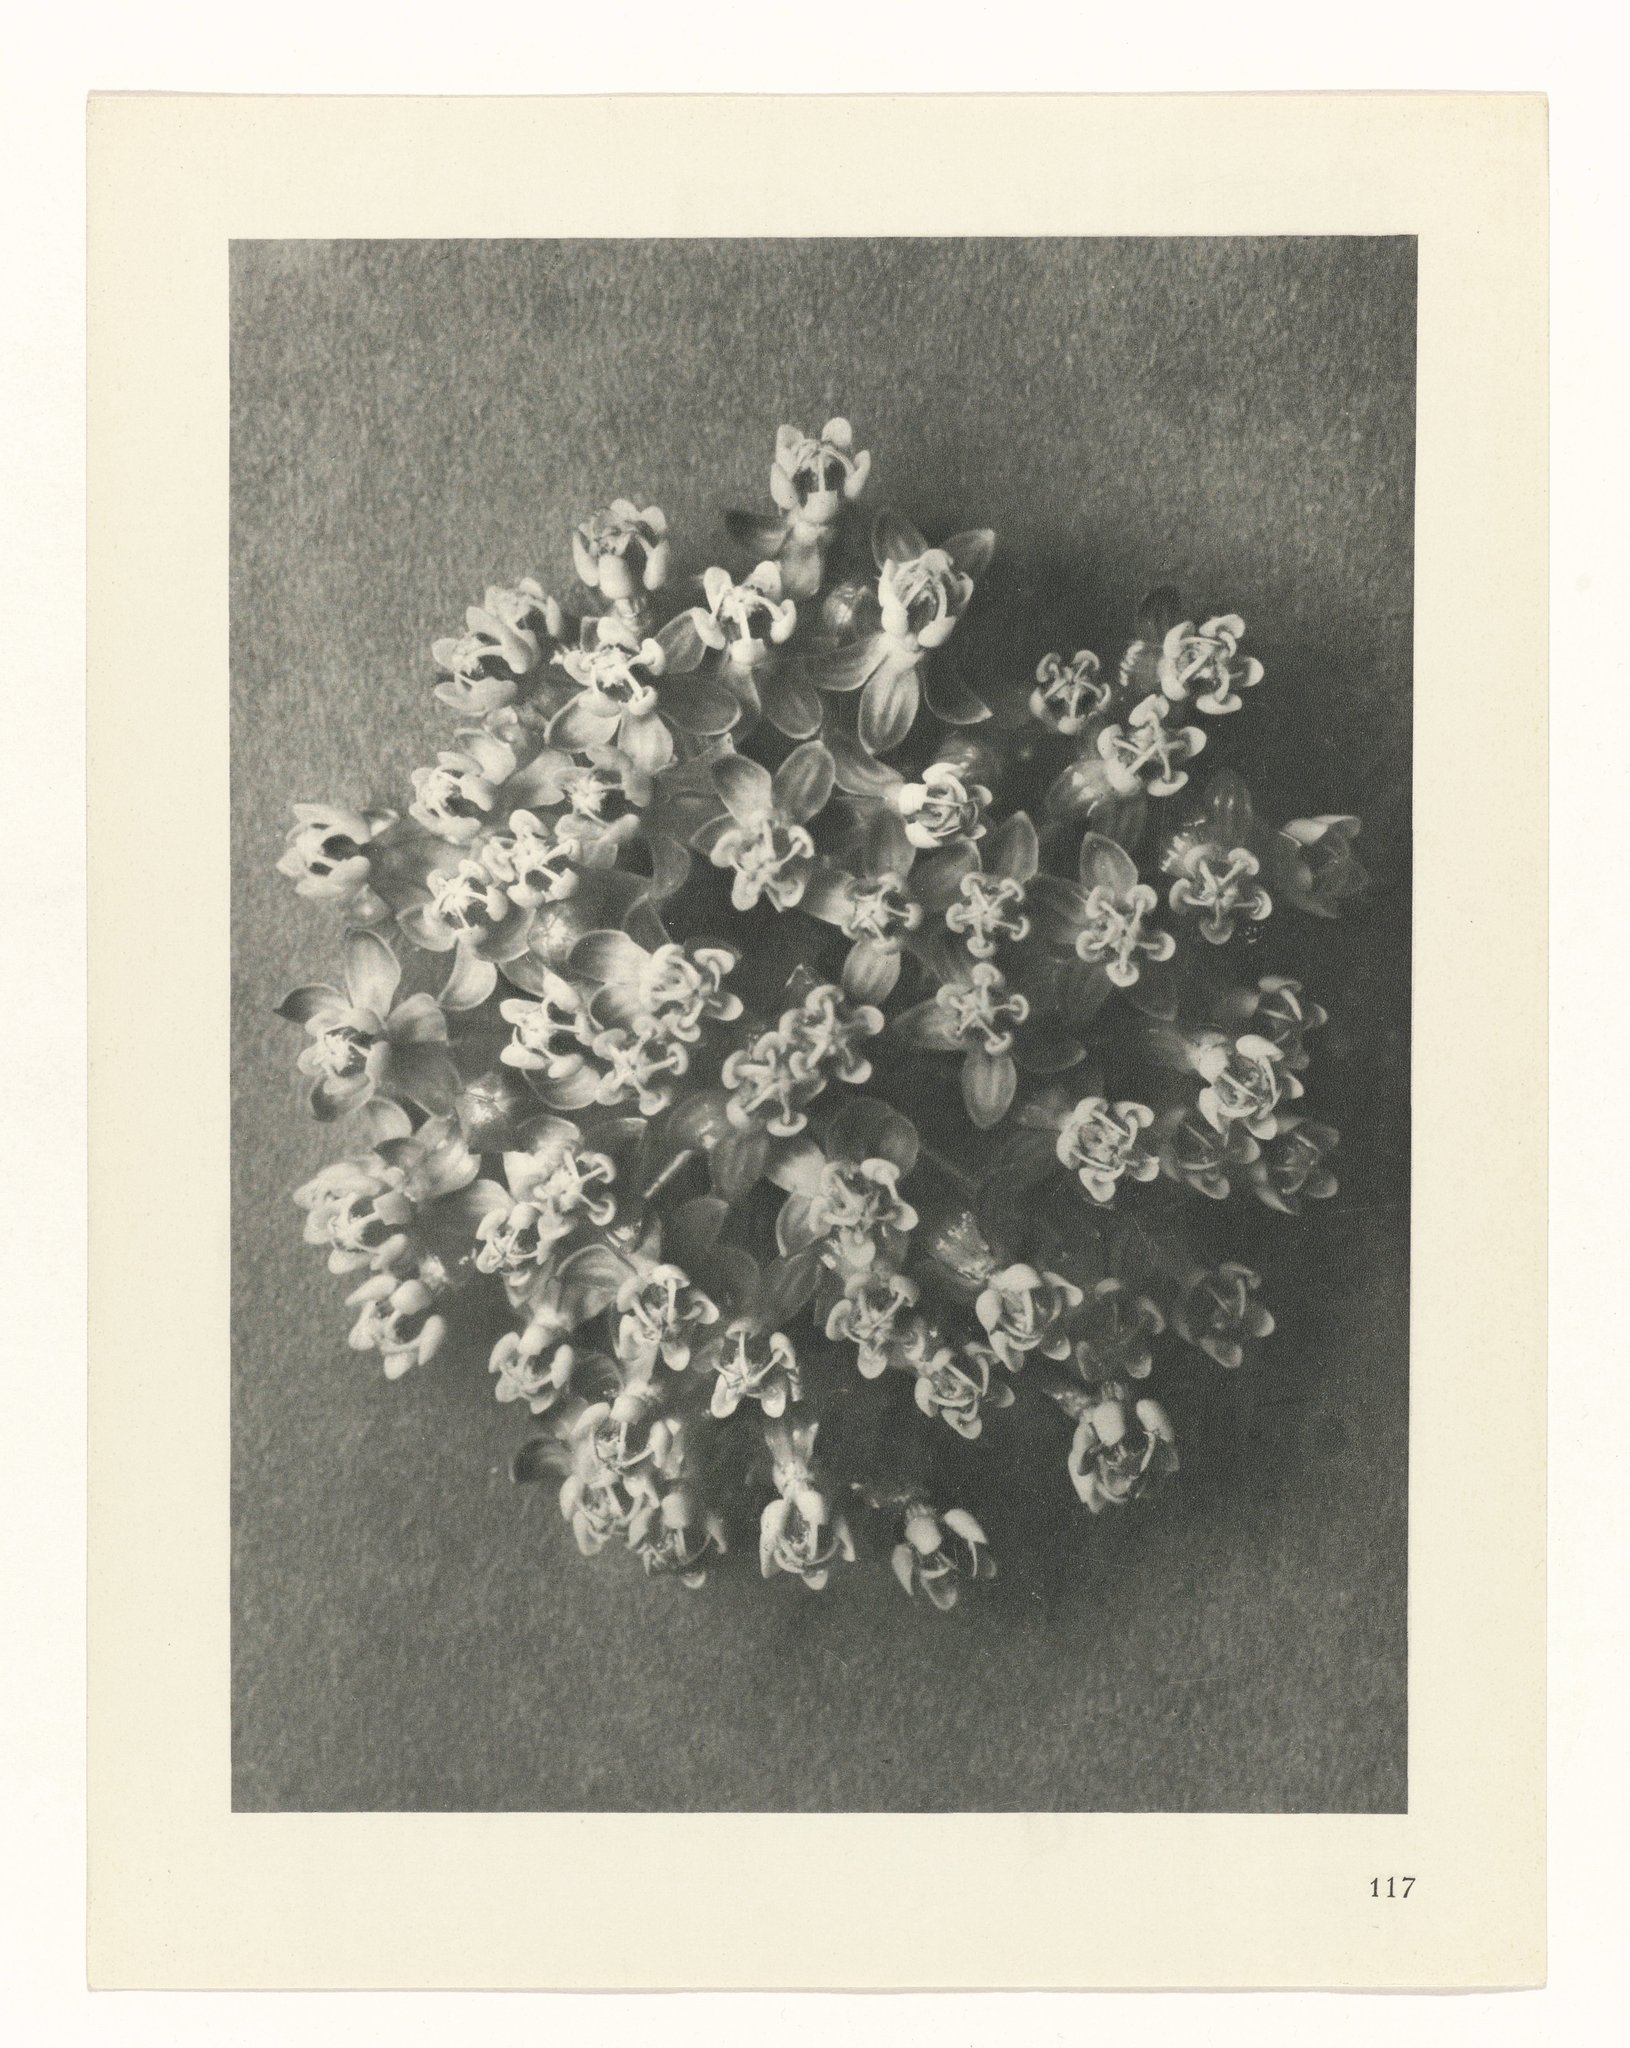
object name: photograph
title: Urformen der Kunst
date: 1928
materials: ink, paper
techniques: rotogravure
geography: berlin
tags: plants (in general)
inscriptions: number: ‘117’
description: facher Vergrößerung. Afkomstig uit losbladige uitgave.